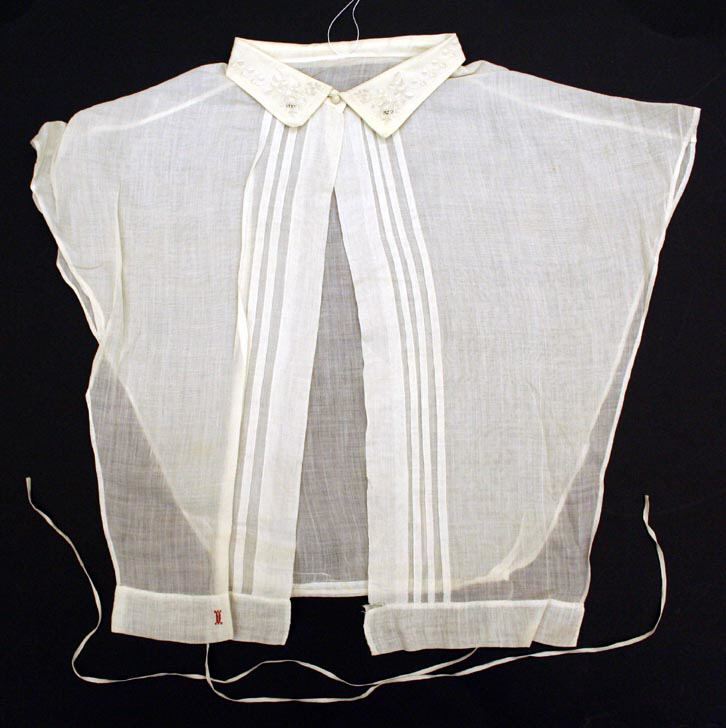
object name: accessory set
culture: american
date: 1860-1869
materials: linen